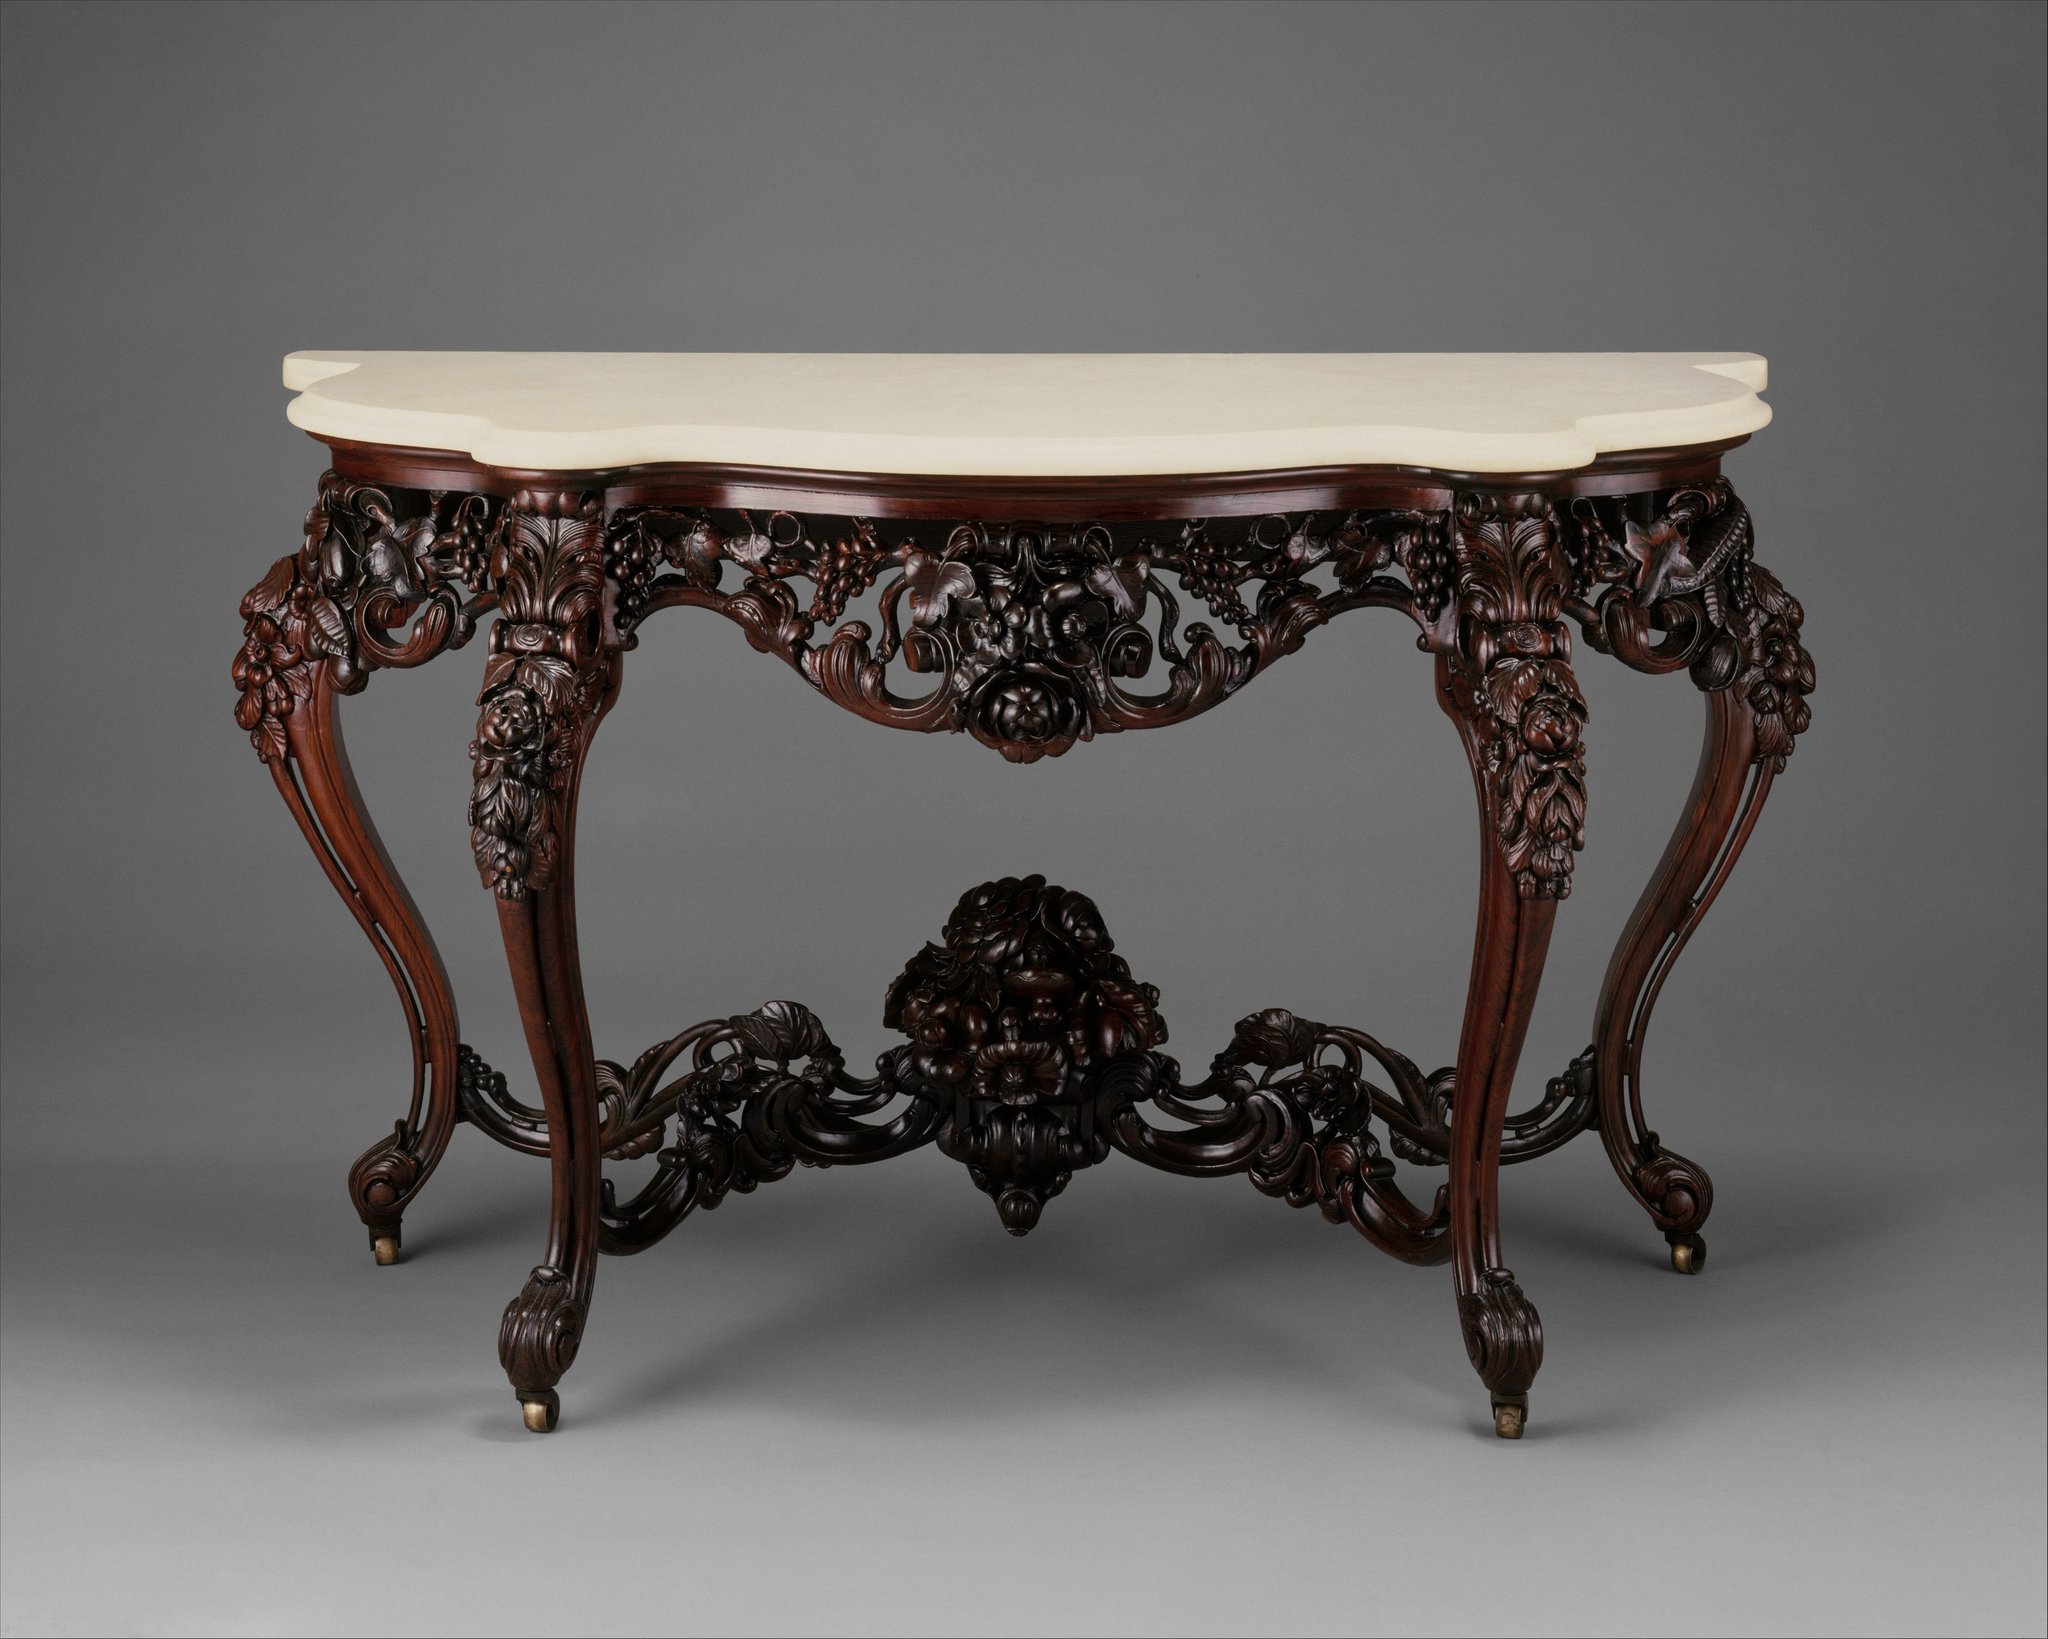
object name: console table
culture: american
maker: john henry belter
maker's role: maker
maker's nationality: american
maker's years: 1804-1863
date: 1855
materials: marble, wood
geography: united states